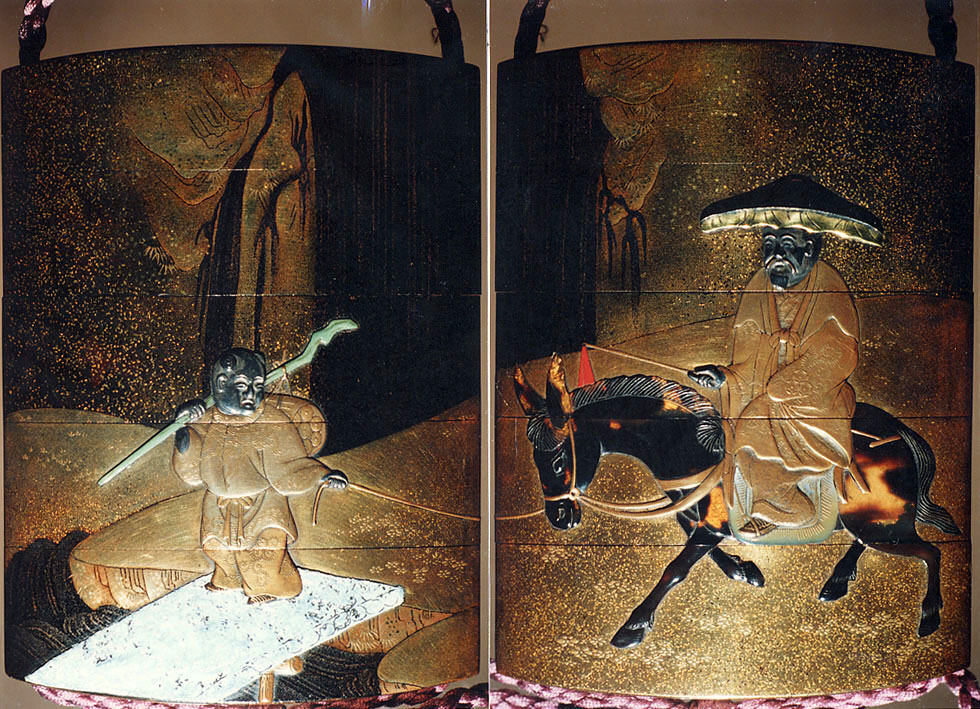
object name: inrō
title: Case (Inrō) with Design of Chinese Horseman Seated on Mule (obverse); Karako on Bridge before Waterfall (reverse)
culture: japanese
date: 1867-1900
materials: gold, lacquer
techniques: fundame, hiramakie, inlay, roiro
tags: men,donkeys